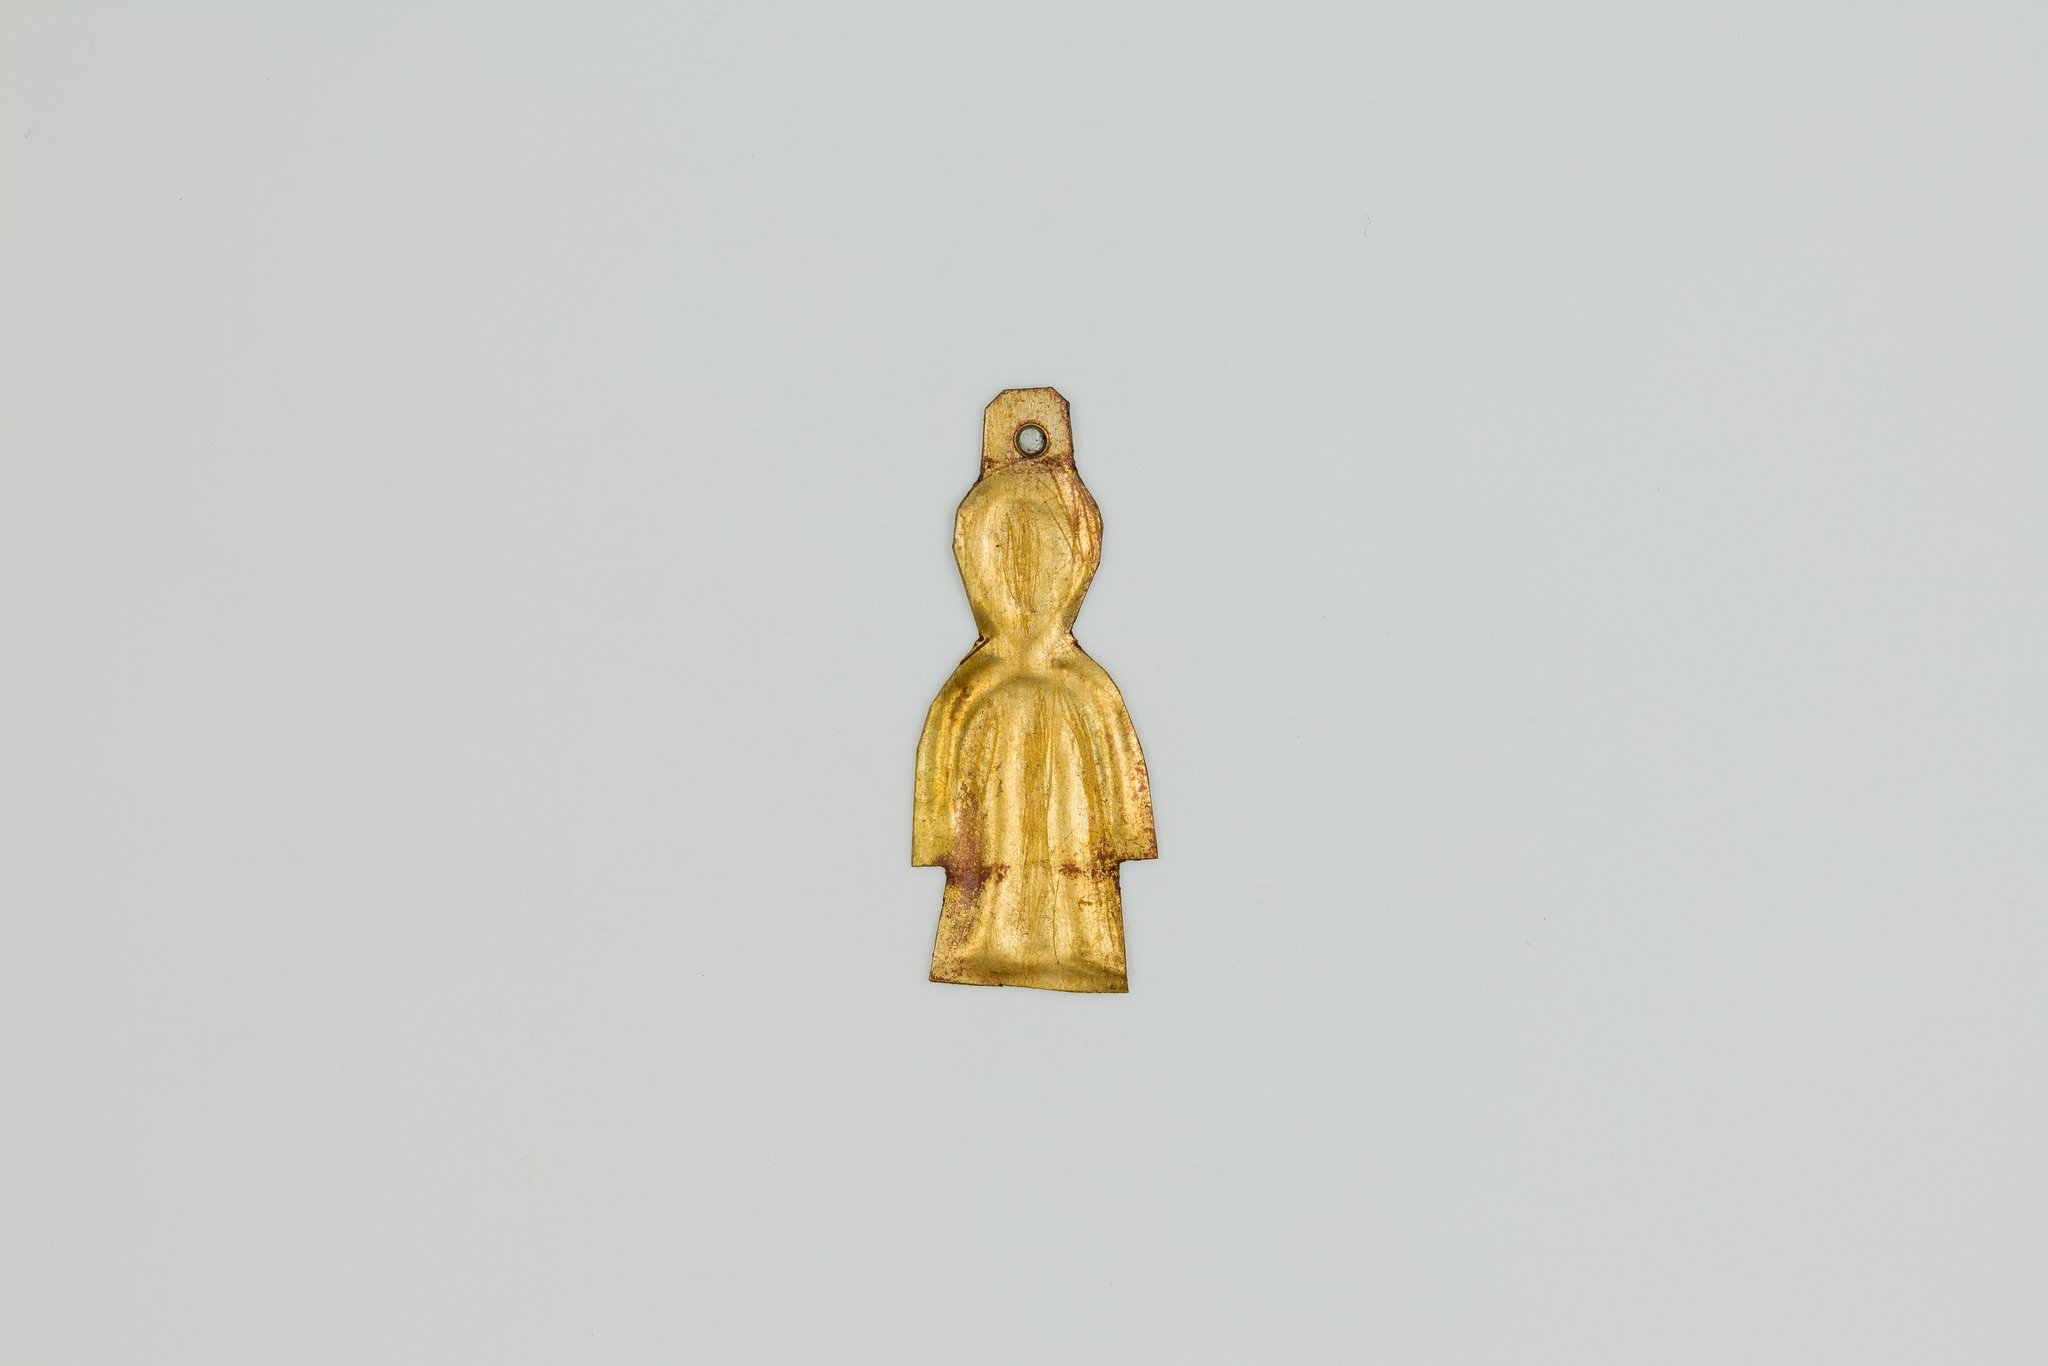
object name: amulet, tit, isi knot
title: Tit (Isis knot) amulet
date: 664-380 BCE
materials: gold